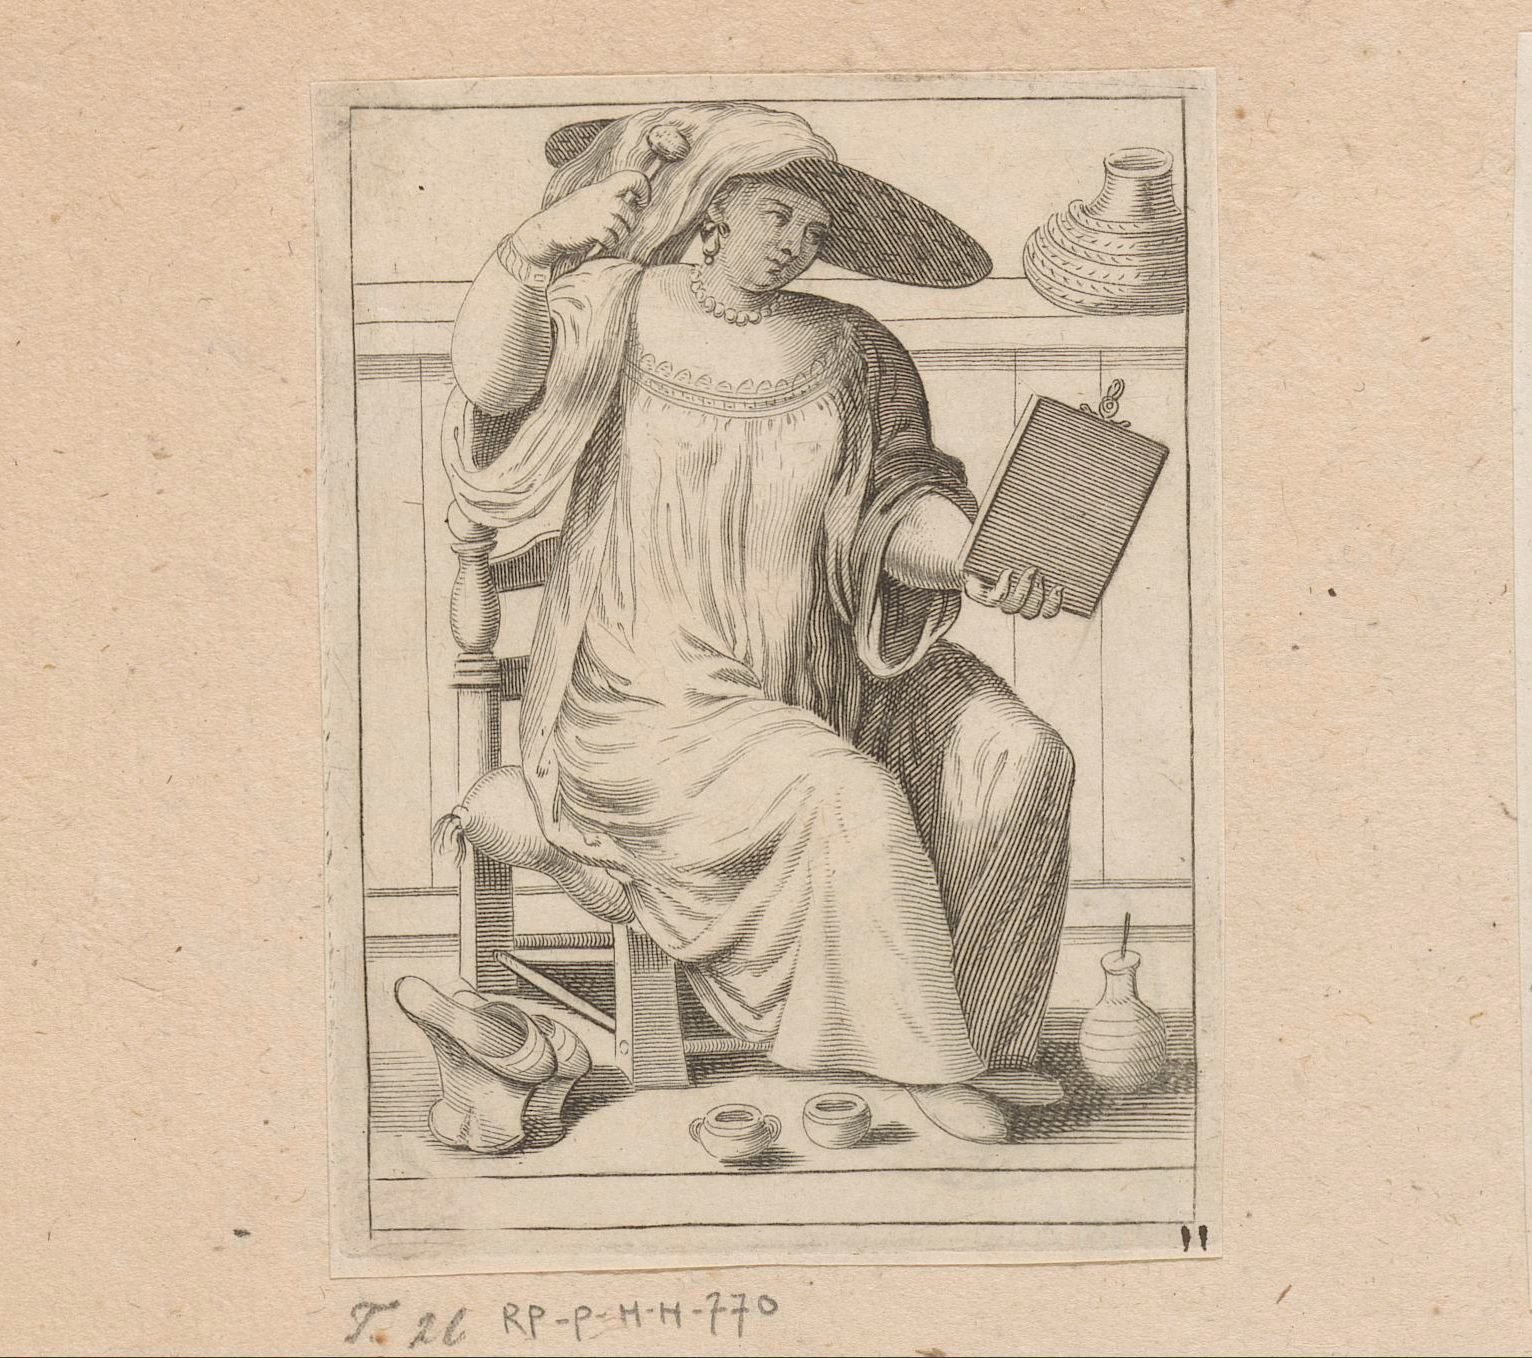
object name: print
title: Vrouw die haar haren blondeert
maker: francesco villamena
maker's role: draughtsman, painter, print maker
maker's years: 1566-1624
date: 1576-1624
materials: paper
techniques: engraving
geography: venice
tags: comb, brush and other tools (care of the hair), folk costume, regional costume, care of the hair, making toilet - aa - (for) women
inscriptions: number: ‘11’, collector's mark: Lugt 10, collector's mark: Lugt 11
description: Een vrouw zittend op een stoel met op het hoofd een hoed met brede rand. Haar haren zijn door de opengewerkte bovenkant van de hoed heen getrokken, opdat deze door de zon worden geblondeerd. In de linkerhand houdt zij een spiegel en in de rechterhand een spons waarmee zij de haren bevochtigt.